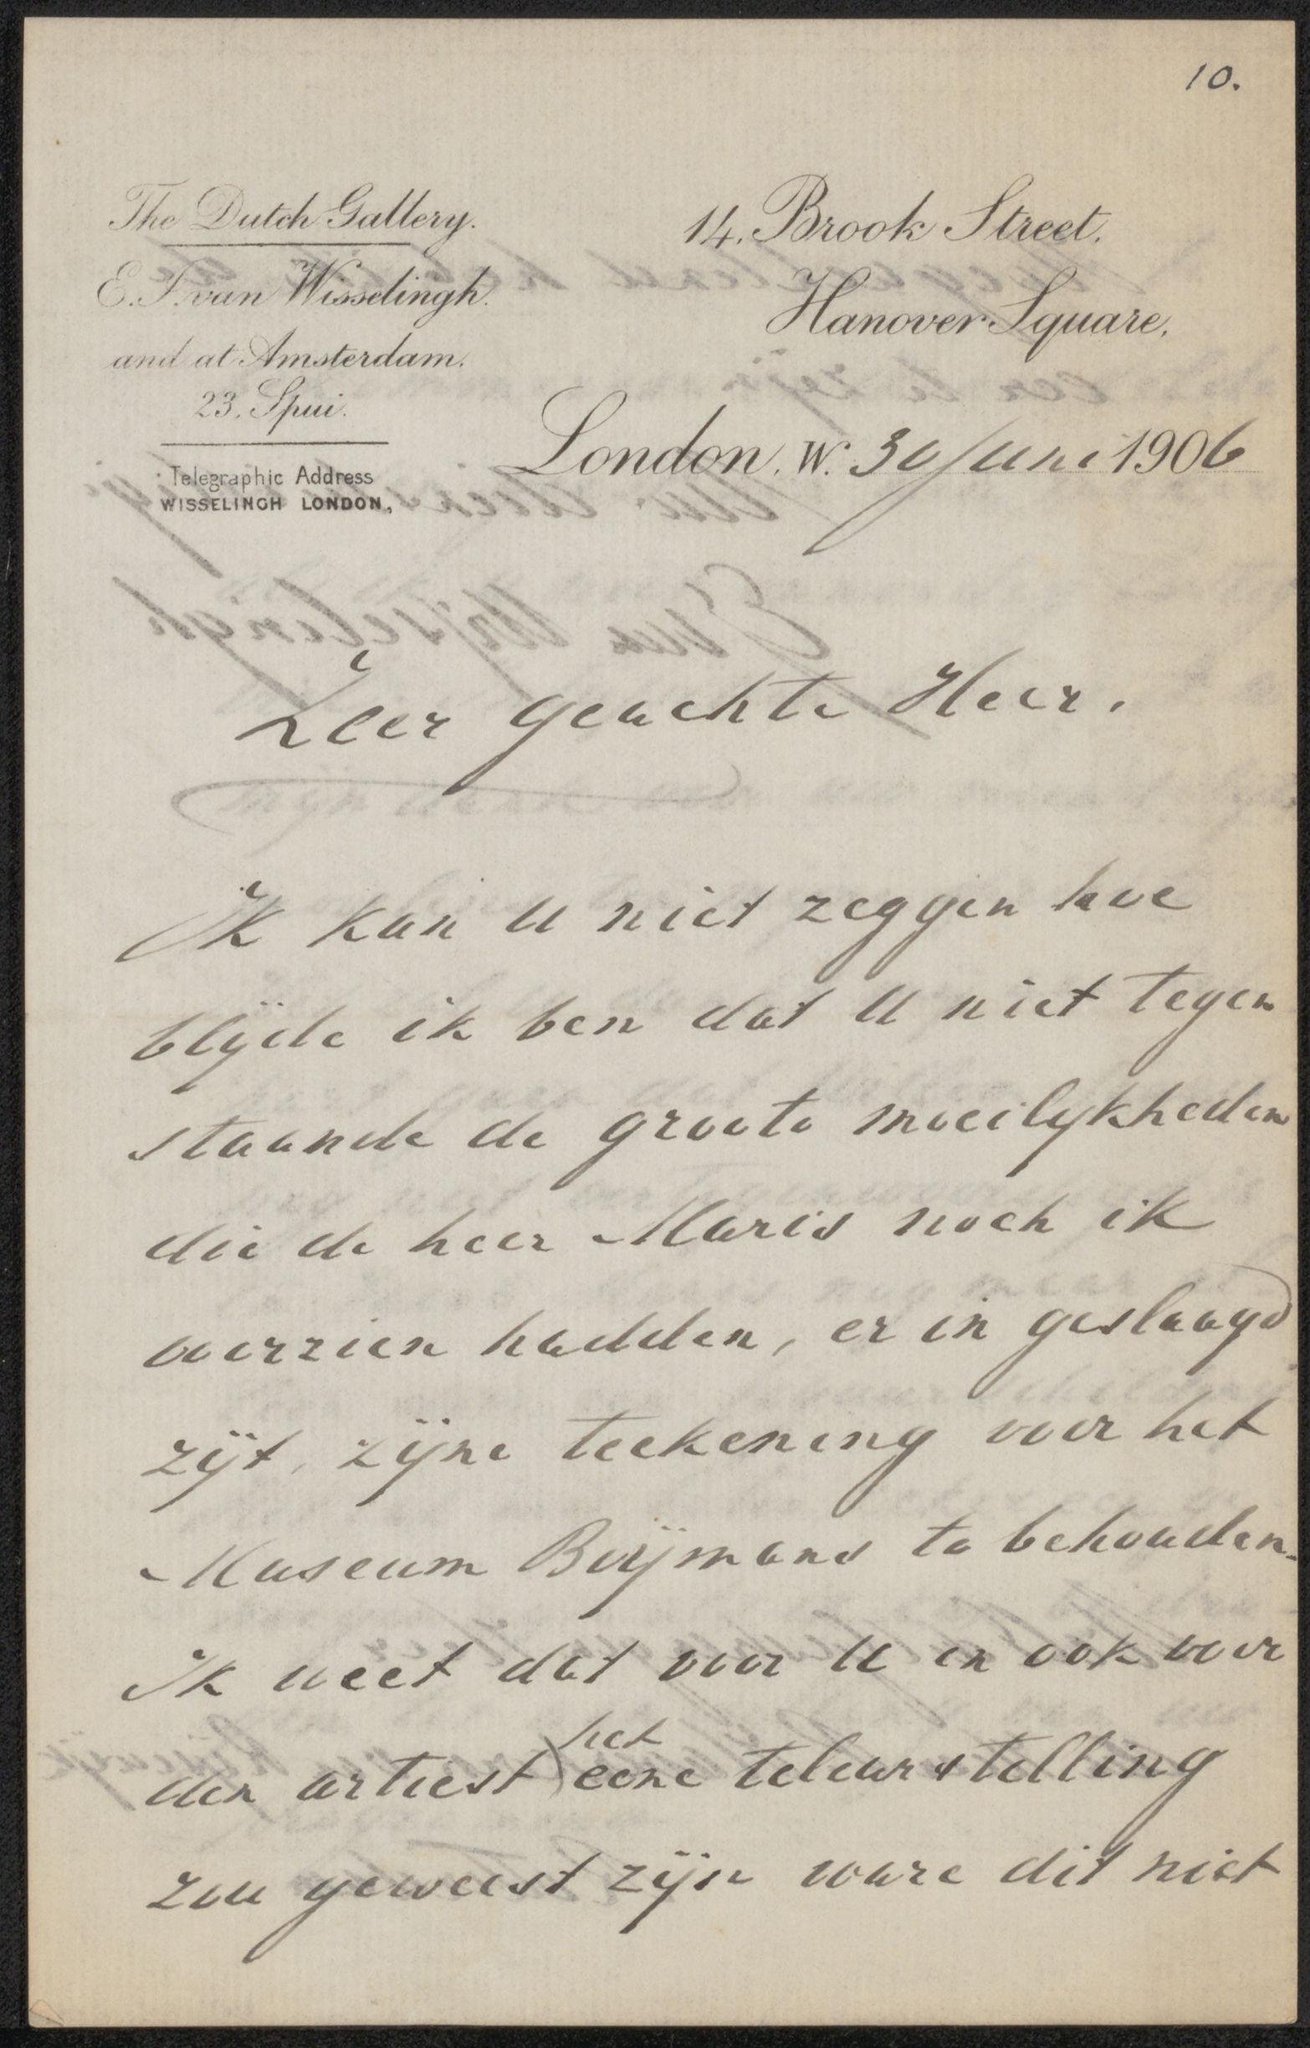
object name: letter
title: Brief aan Pieter Haverkorn van Rijsewijk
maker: elbert jan van wisselingh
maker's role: kunsthandelaar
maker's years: 1848-1912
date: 1906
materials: ink, paper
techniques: pen, printing, writing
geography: london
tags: the hague, london, painter, print maker, draughtsman, matthijs maris, willem maris, jacob maris, pieter haverkorn van rijsewijk, drawing, painting (including book-illumination, miniature-painting), art collecting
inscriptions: watermark